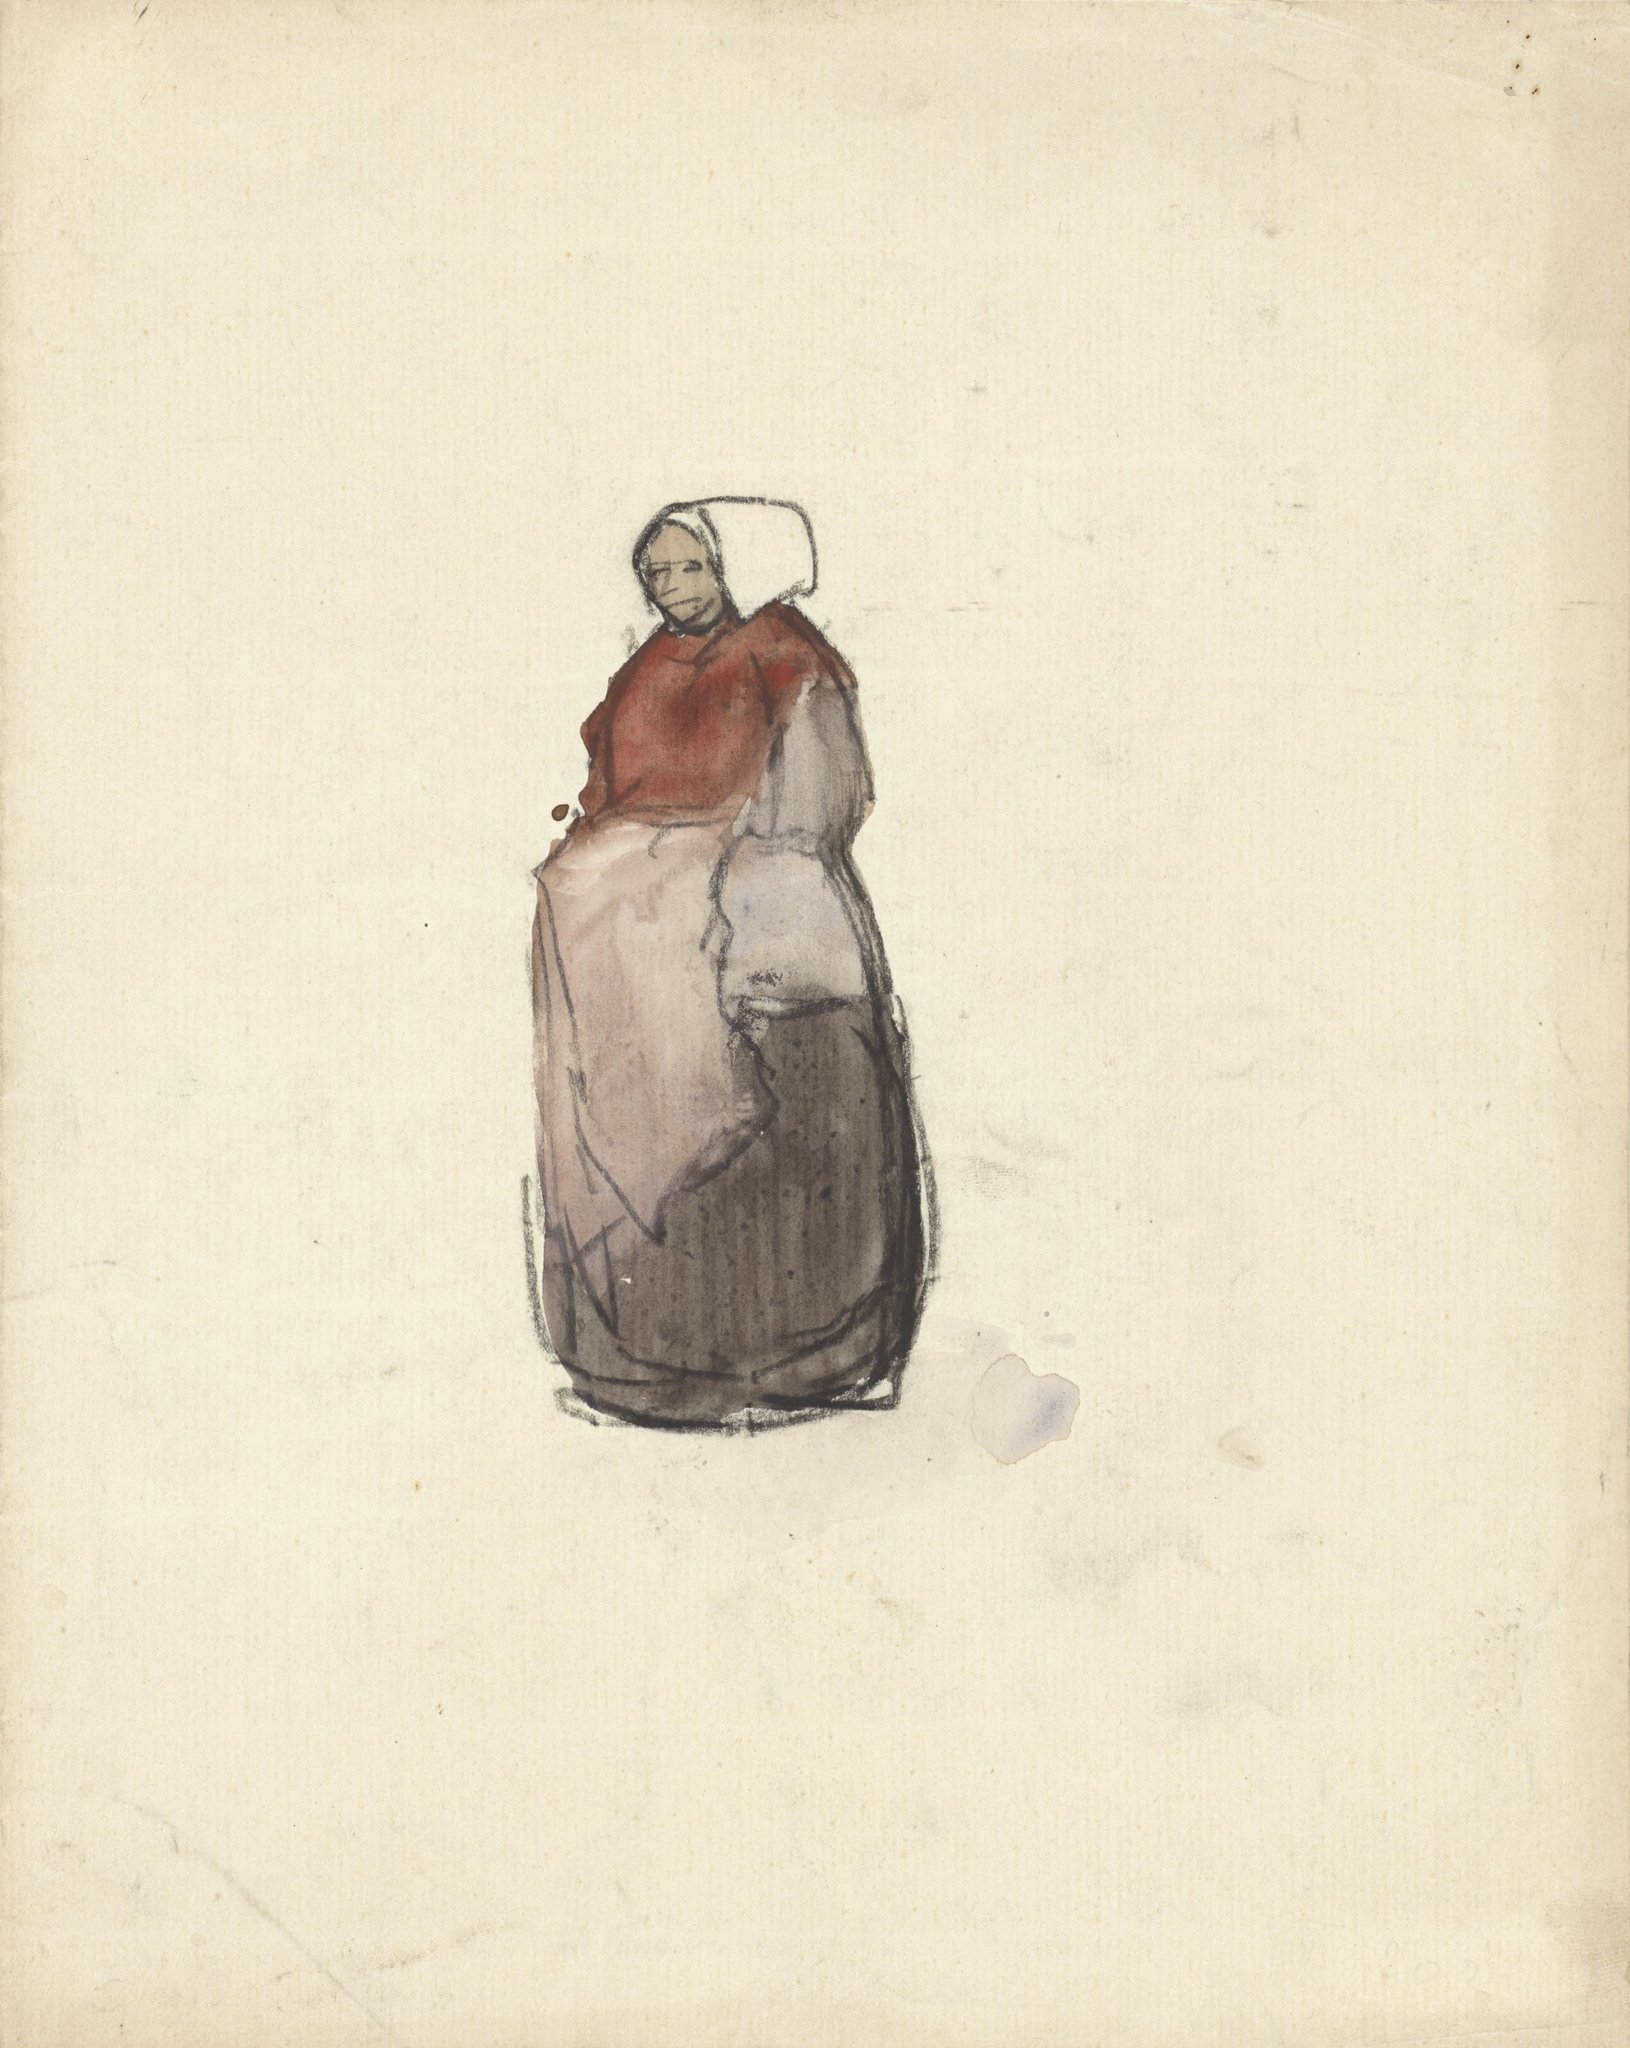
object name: drawing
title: Staande boerin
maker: adolf le comte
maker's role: draughtsman, painter, print maker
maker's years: 1850-1921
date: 1860-1921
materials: chalk, paper, watercolor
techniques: brush